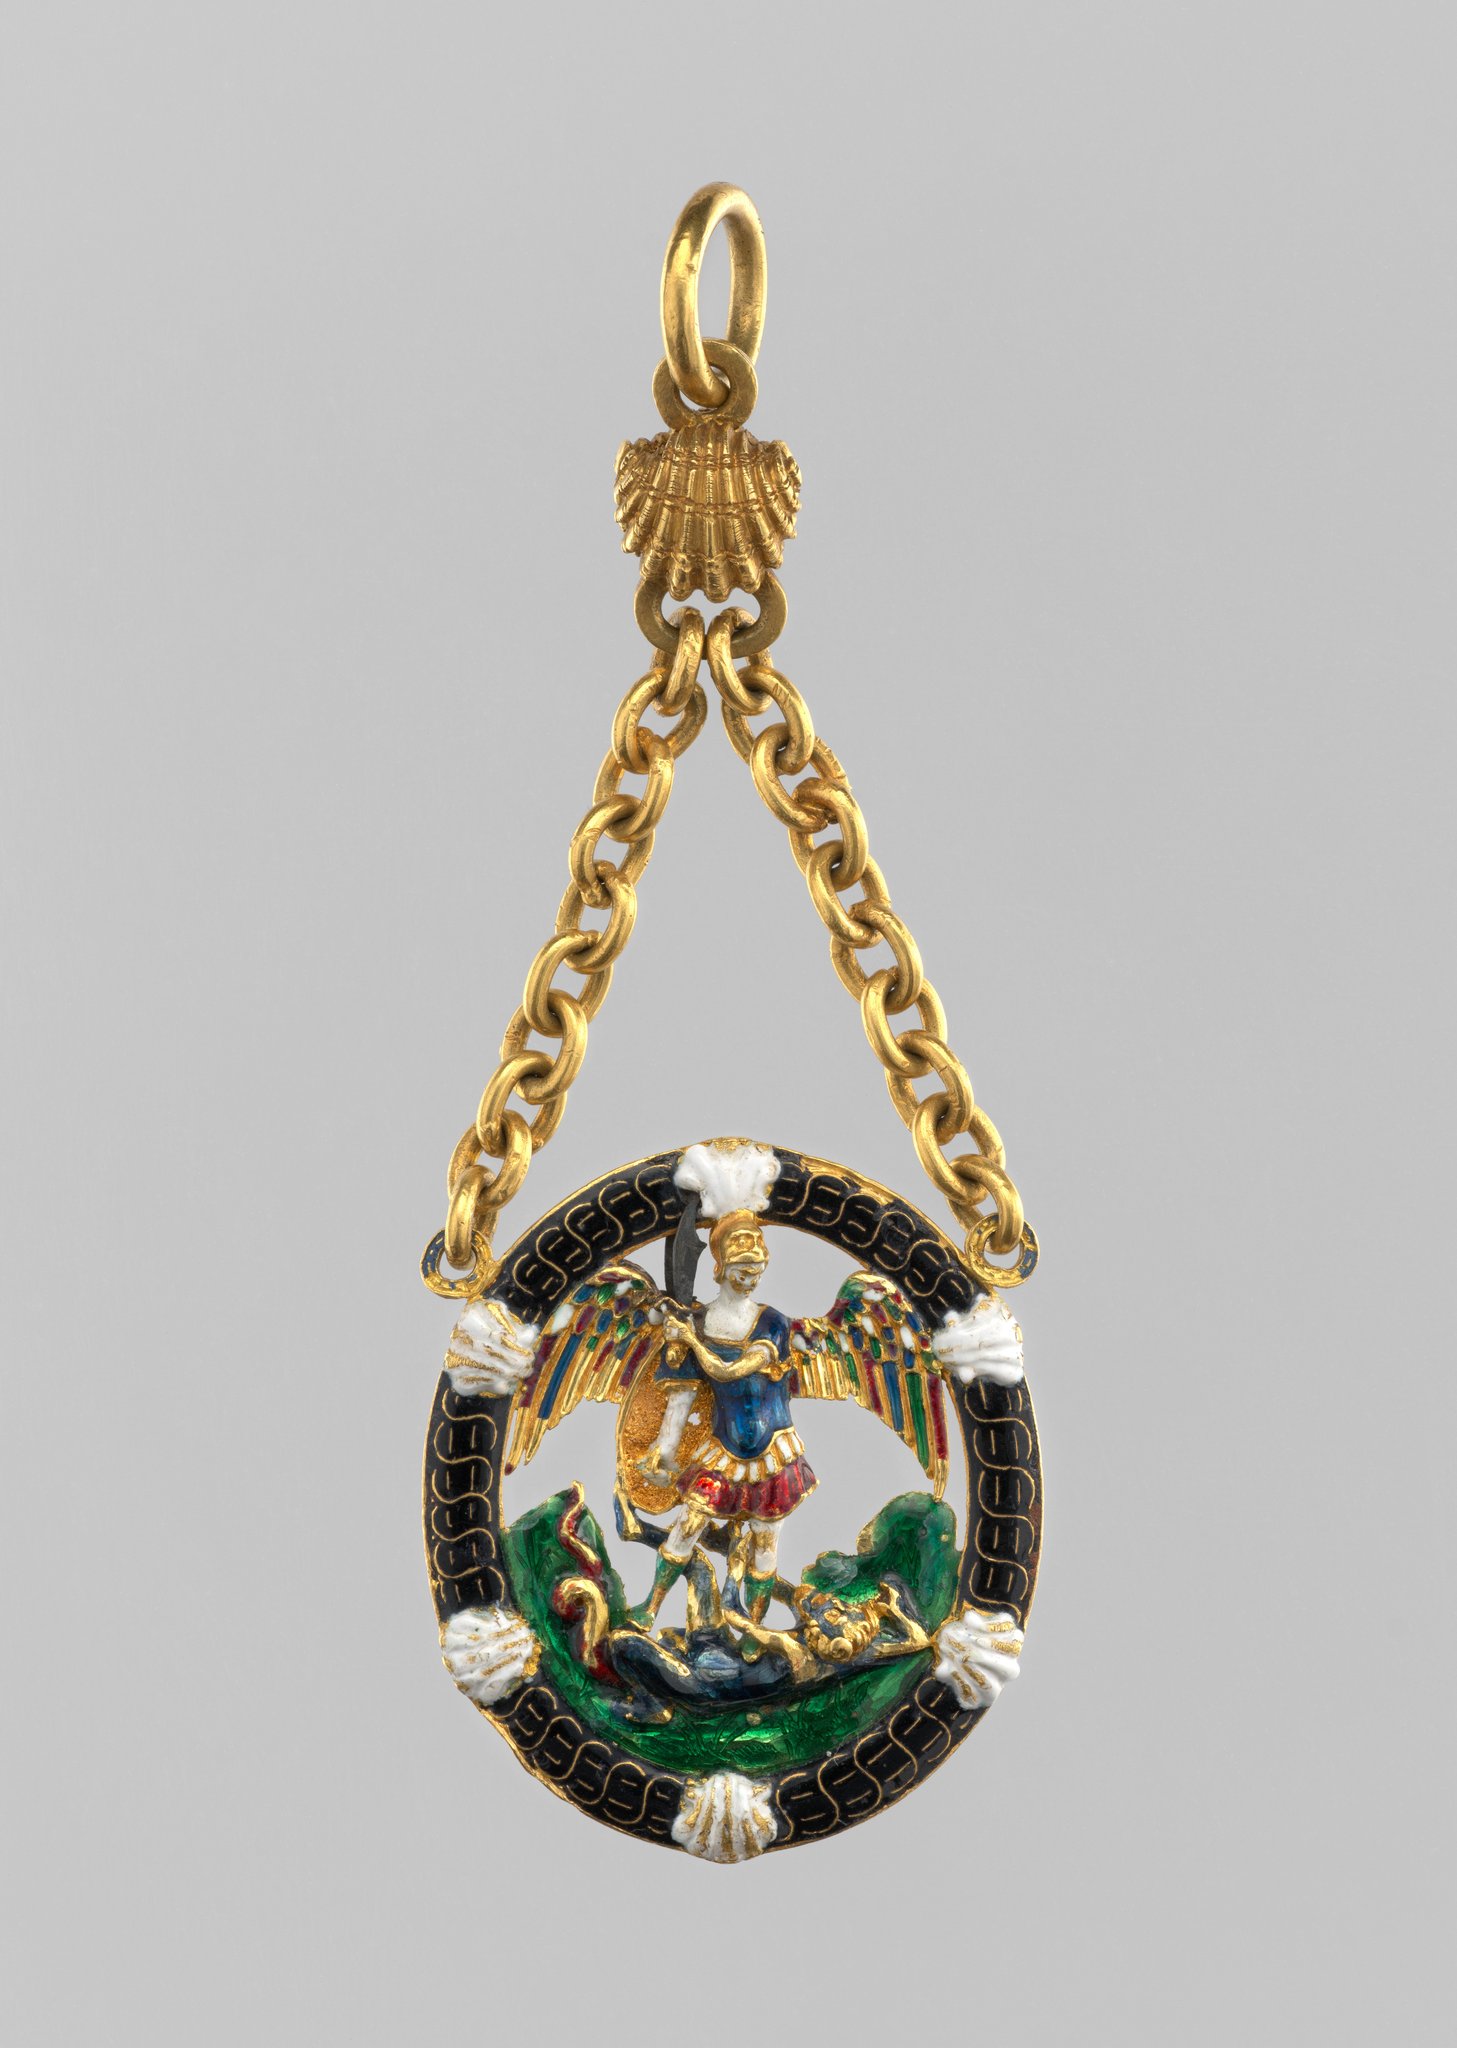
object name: badge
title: Badge of the Order of Saint Michael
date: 1601-1700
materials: enamel, gold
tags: saint michael